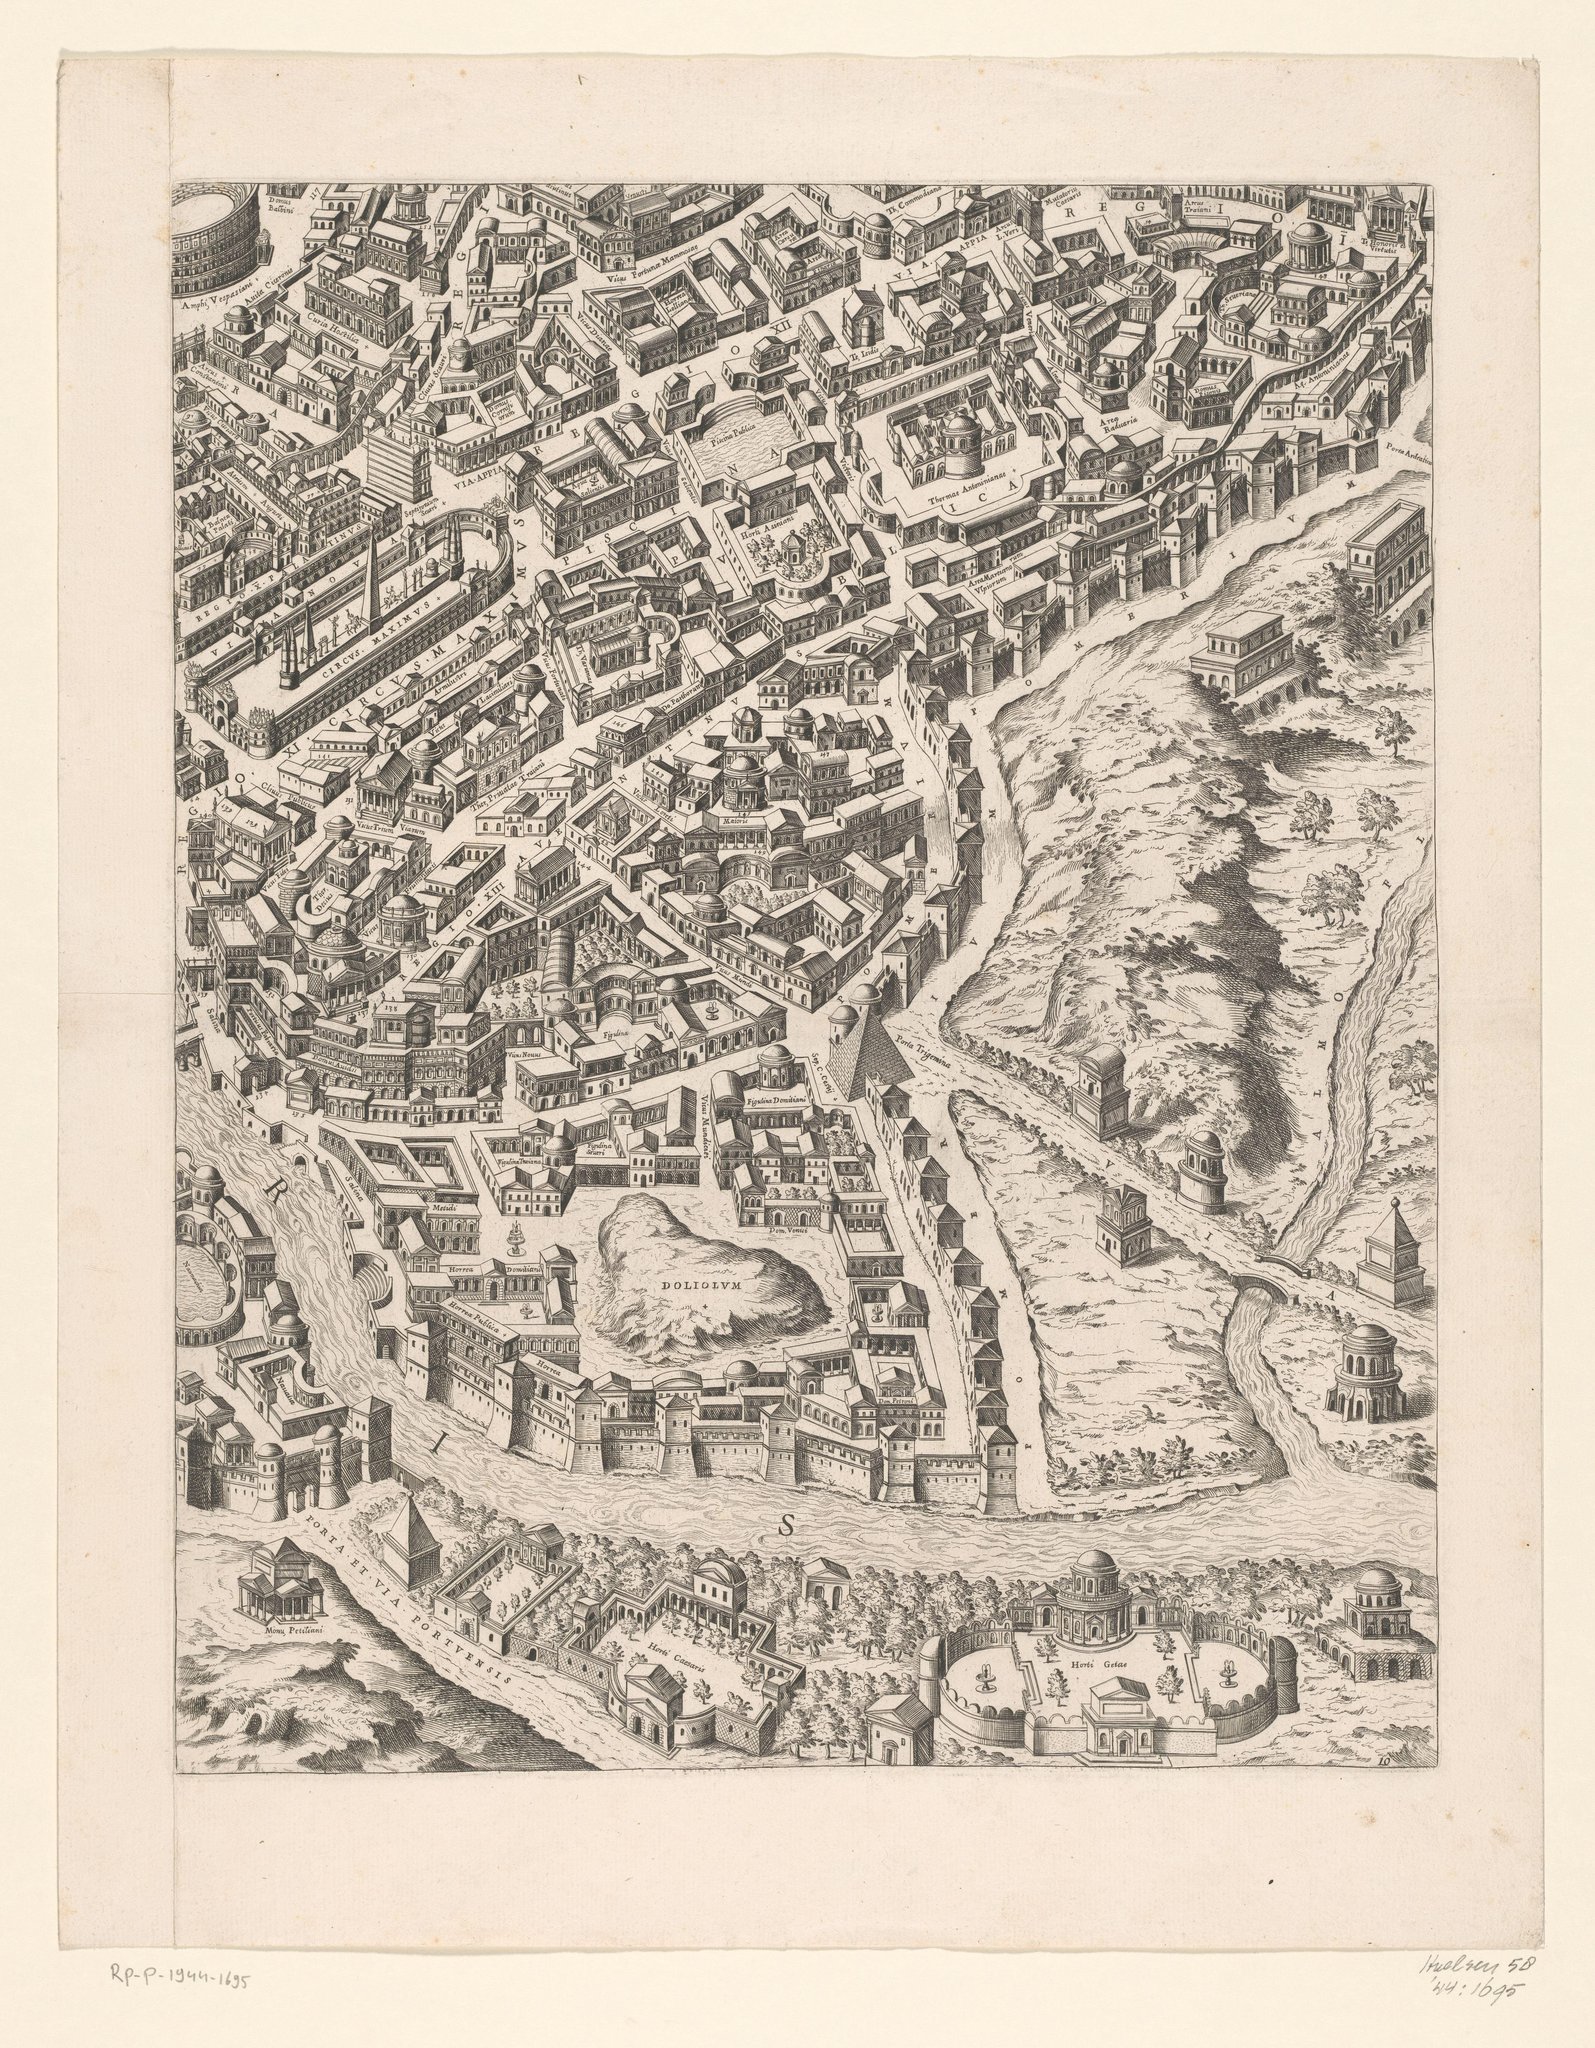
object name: area plan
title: Urbis Romae sciographia ex antiquis monumentis accuratiss delineata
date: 1639-1691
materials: paper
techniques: engraving, etching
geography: rome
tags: maps of cities, rome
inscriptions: collector's mark: Lugt 2228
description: Zevende deel van een plattegrond van Rome in vogelvluchtperspectief, bestaande uit acht delen. Rechtsonder genummerd: 10.